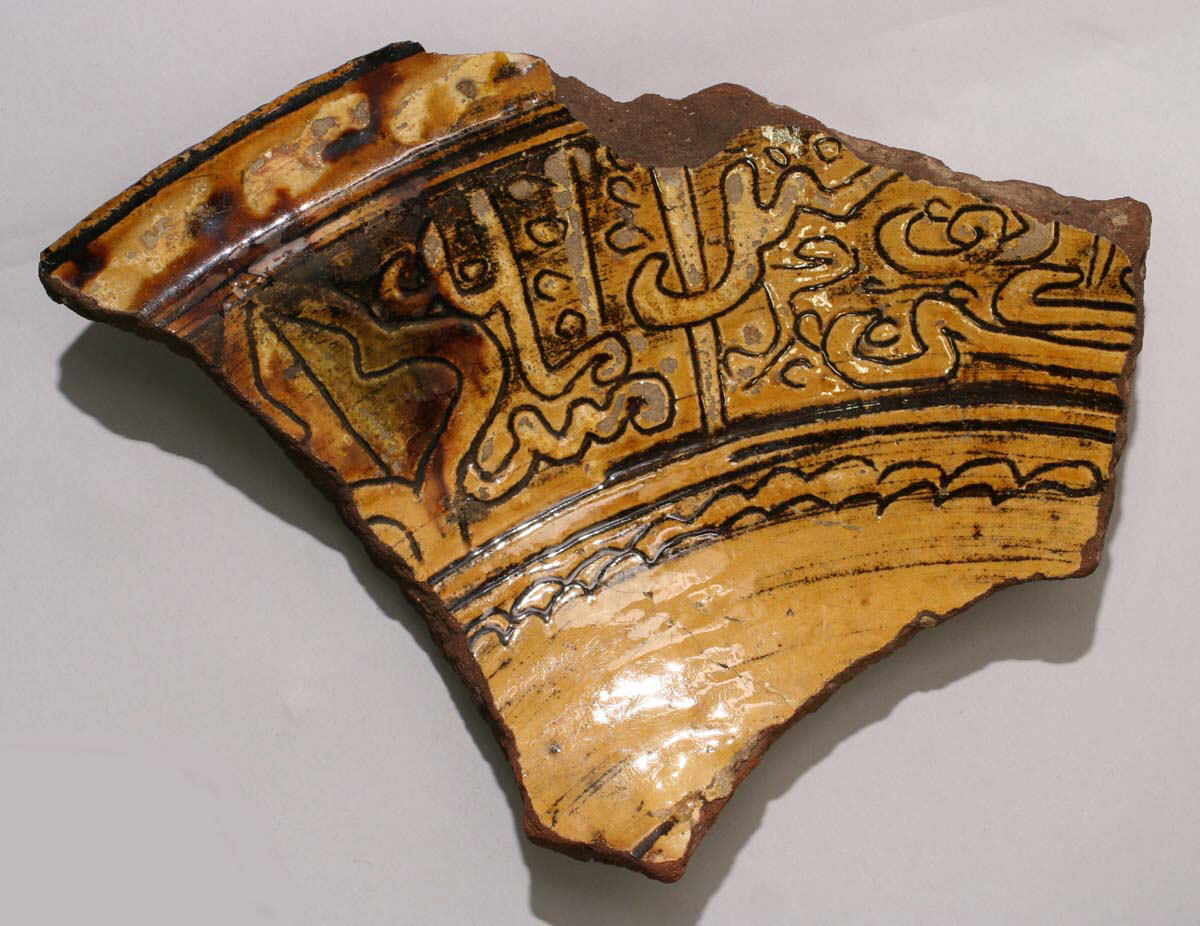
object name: fragment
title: Ceramic Fragment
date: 1301-1500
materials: earthenware, glaze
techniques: coloring, incising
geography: egypt